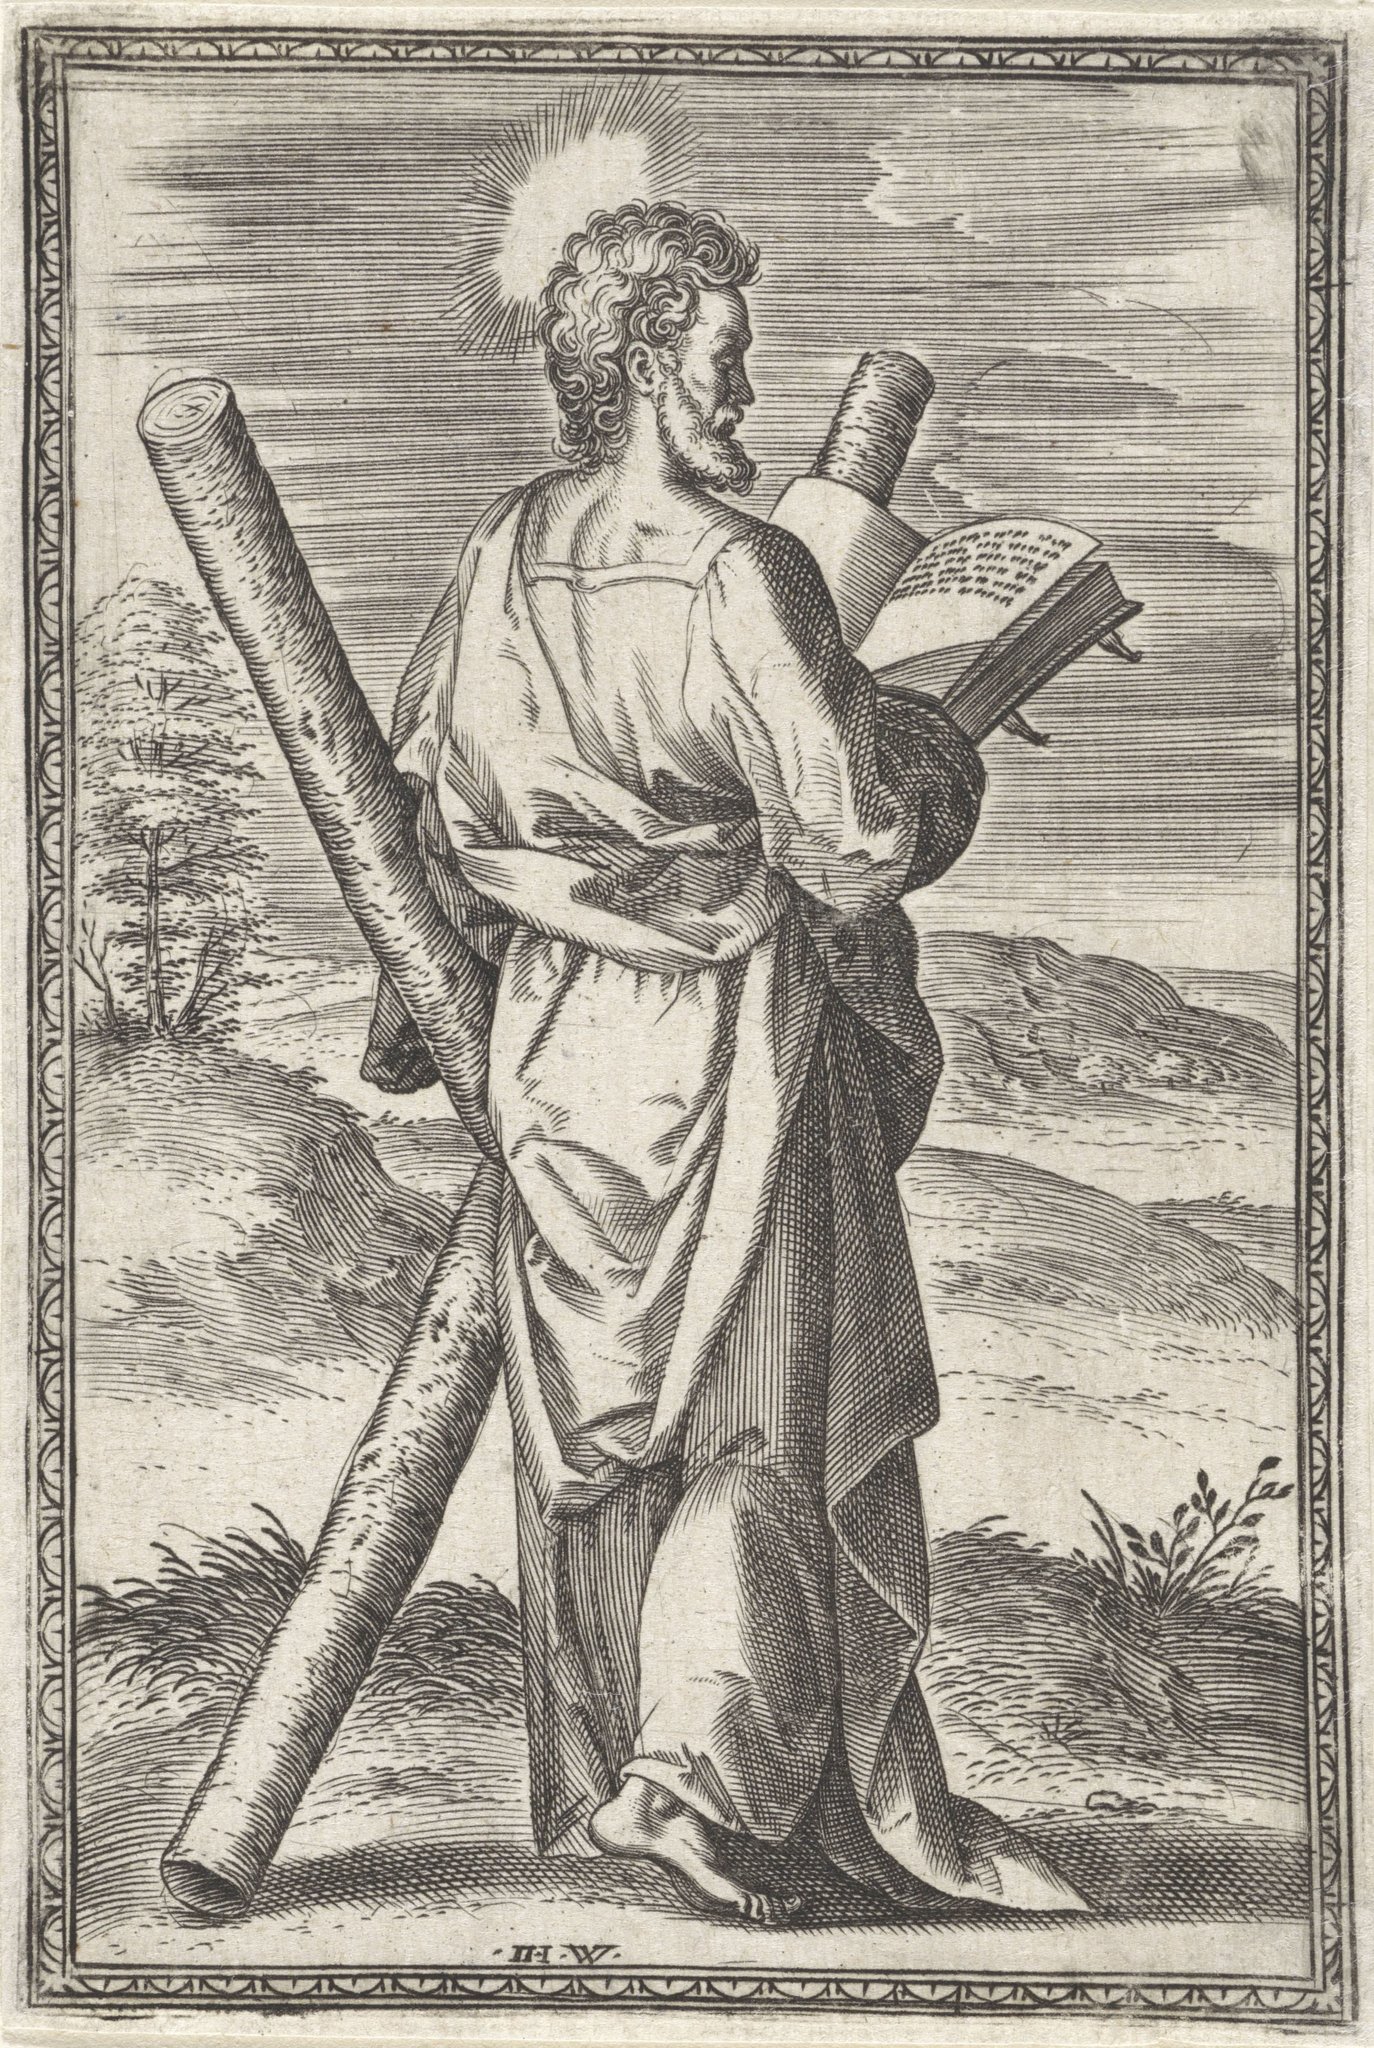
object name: print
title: H. Andreas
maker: johannes wierix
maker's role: draughtsman, print maker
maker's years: 1549-1618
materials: paper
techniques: engraving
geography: antwerp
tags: the apostle andrew; possible attributes: book, x-shaped cross, fish, fishing-net, rope, scroll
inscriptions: collector's mark: Lugt 2228, number: ‘38. - 84.’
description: Landschap met de apostel Andreas, op de rug gezien. Hij leest in het opengeslagen boek in zijn hand. Onder zijn arm houdt hij het x-vormig kruis.